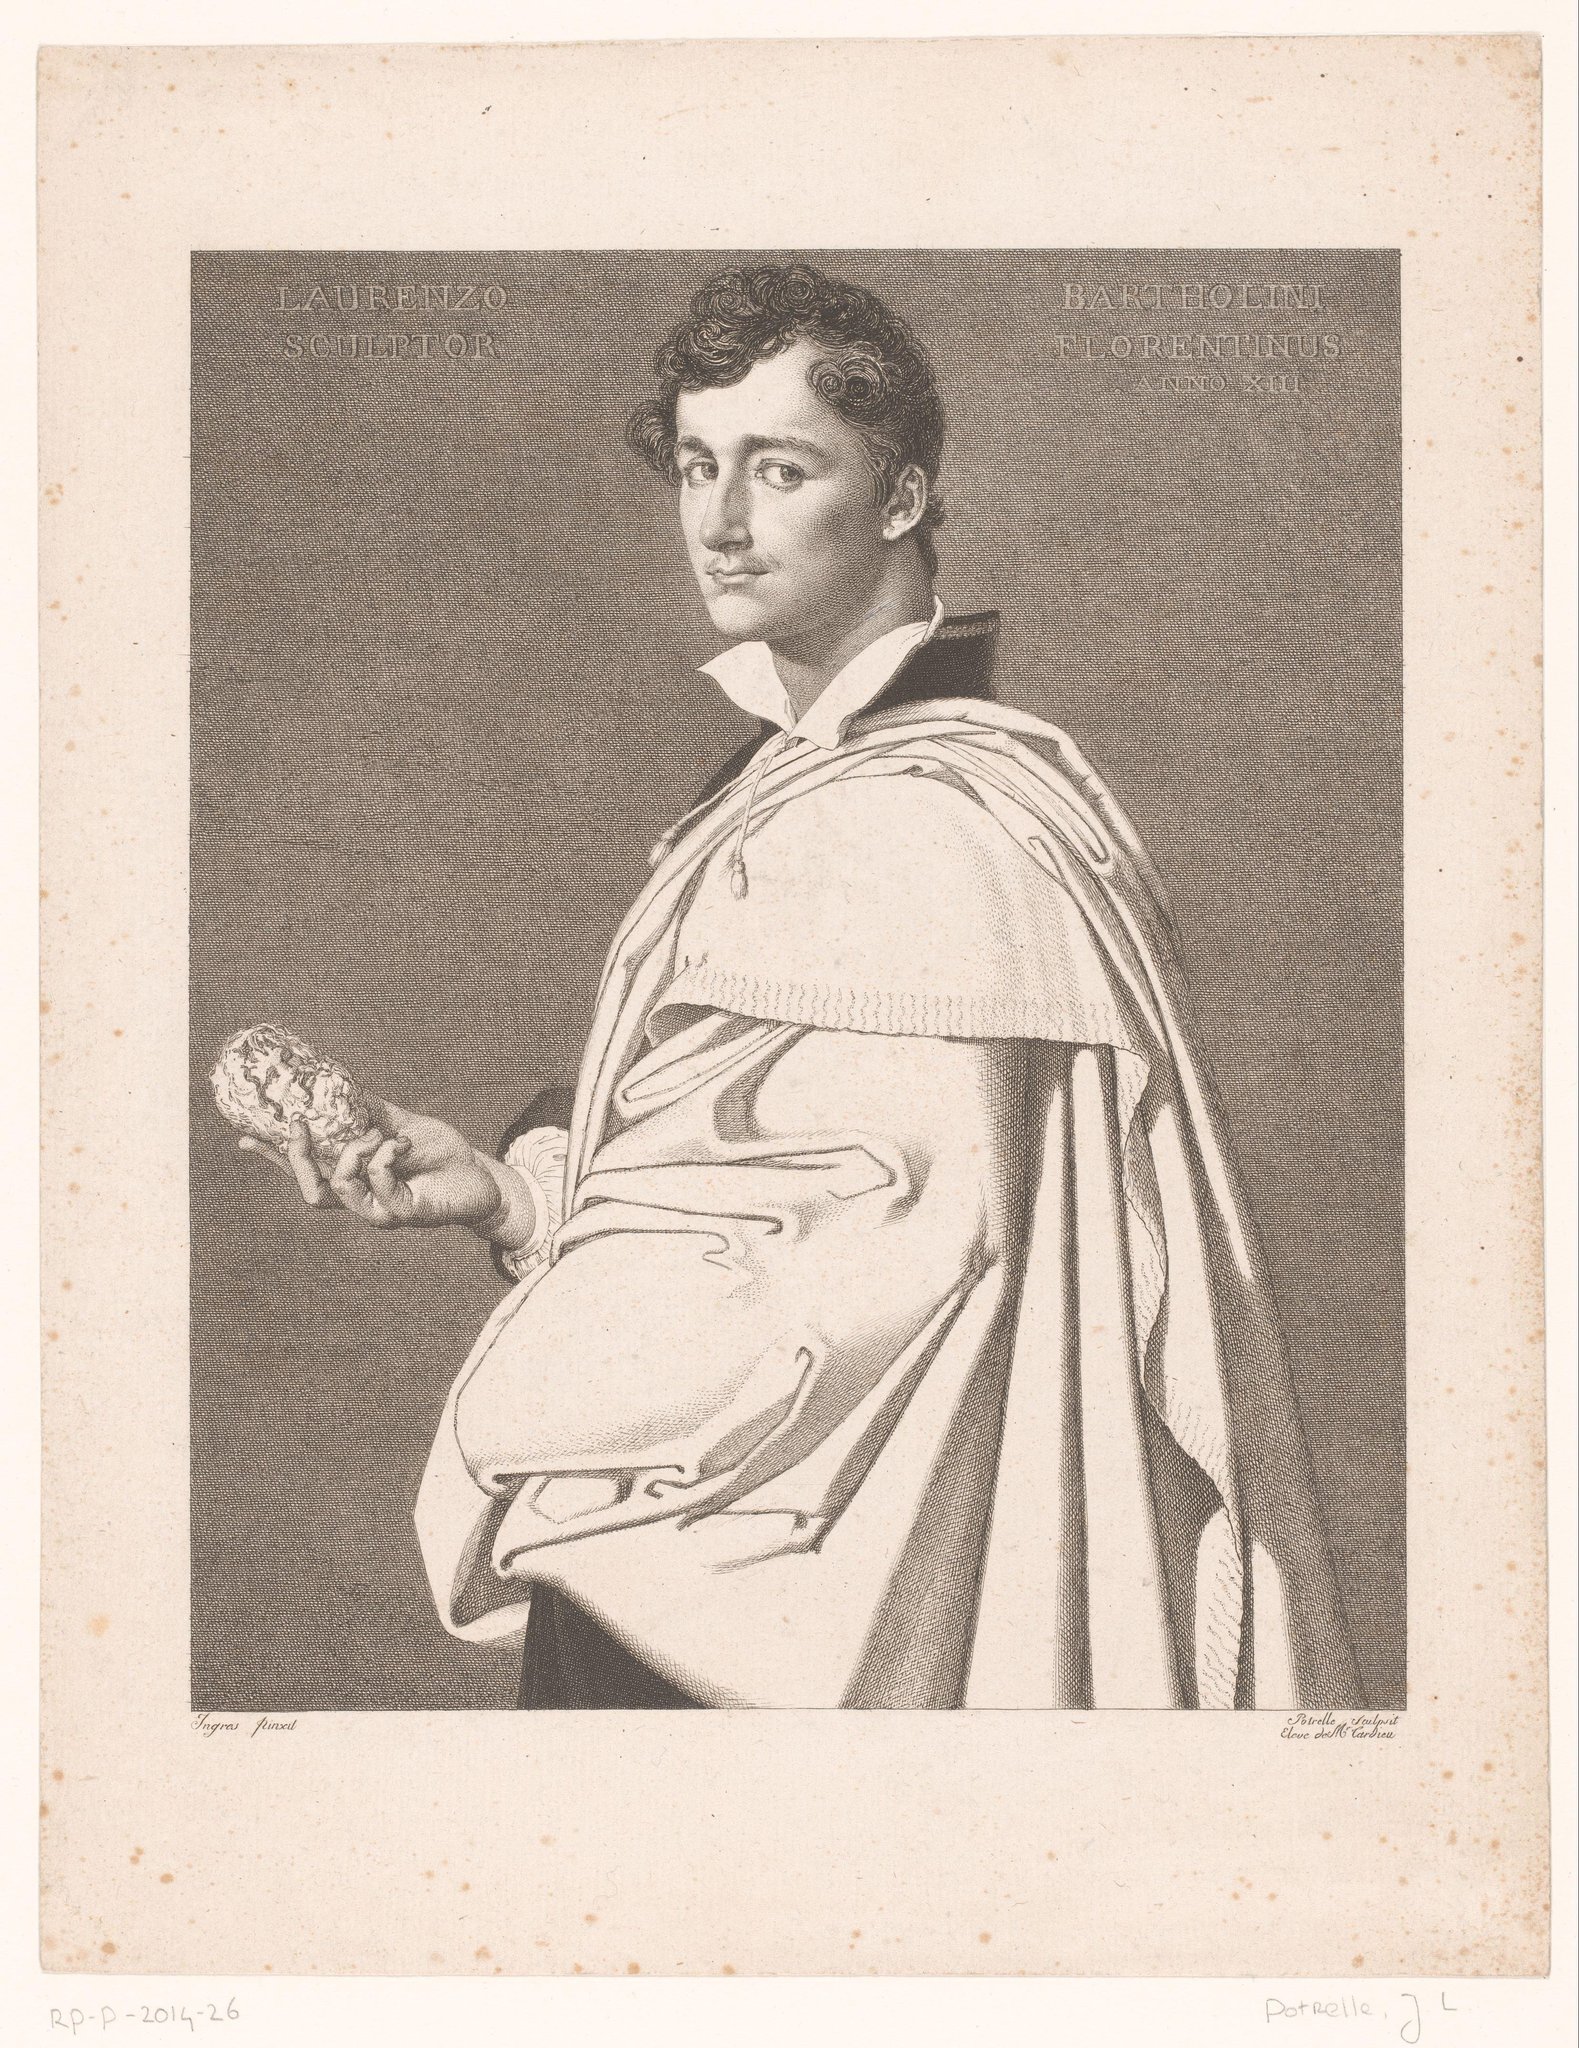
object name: print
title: Portret van de beeldhouwer Lorenzo Bartolini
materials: paper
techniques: engraving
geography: france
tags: draughtsman, sculptor, lorenzo bartolini, portrait, self-portrait of sculptor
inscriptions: collector's mark: Lugt 2760, collector's mark: Lugt 2228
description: Het schilderij van Ingres waarnaar deze portretprent is uitgevoerd, wordt bewaard in Musée Ingres in Montauban en dateert uit 1805. In dit schilderij is de draperie donker.